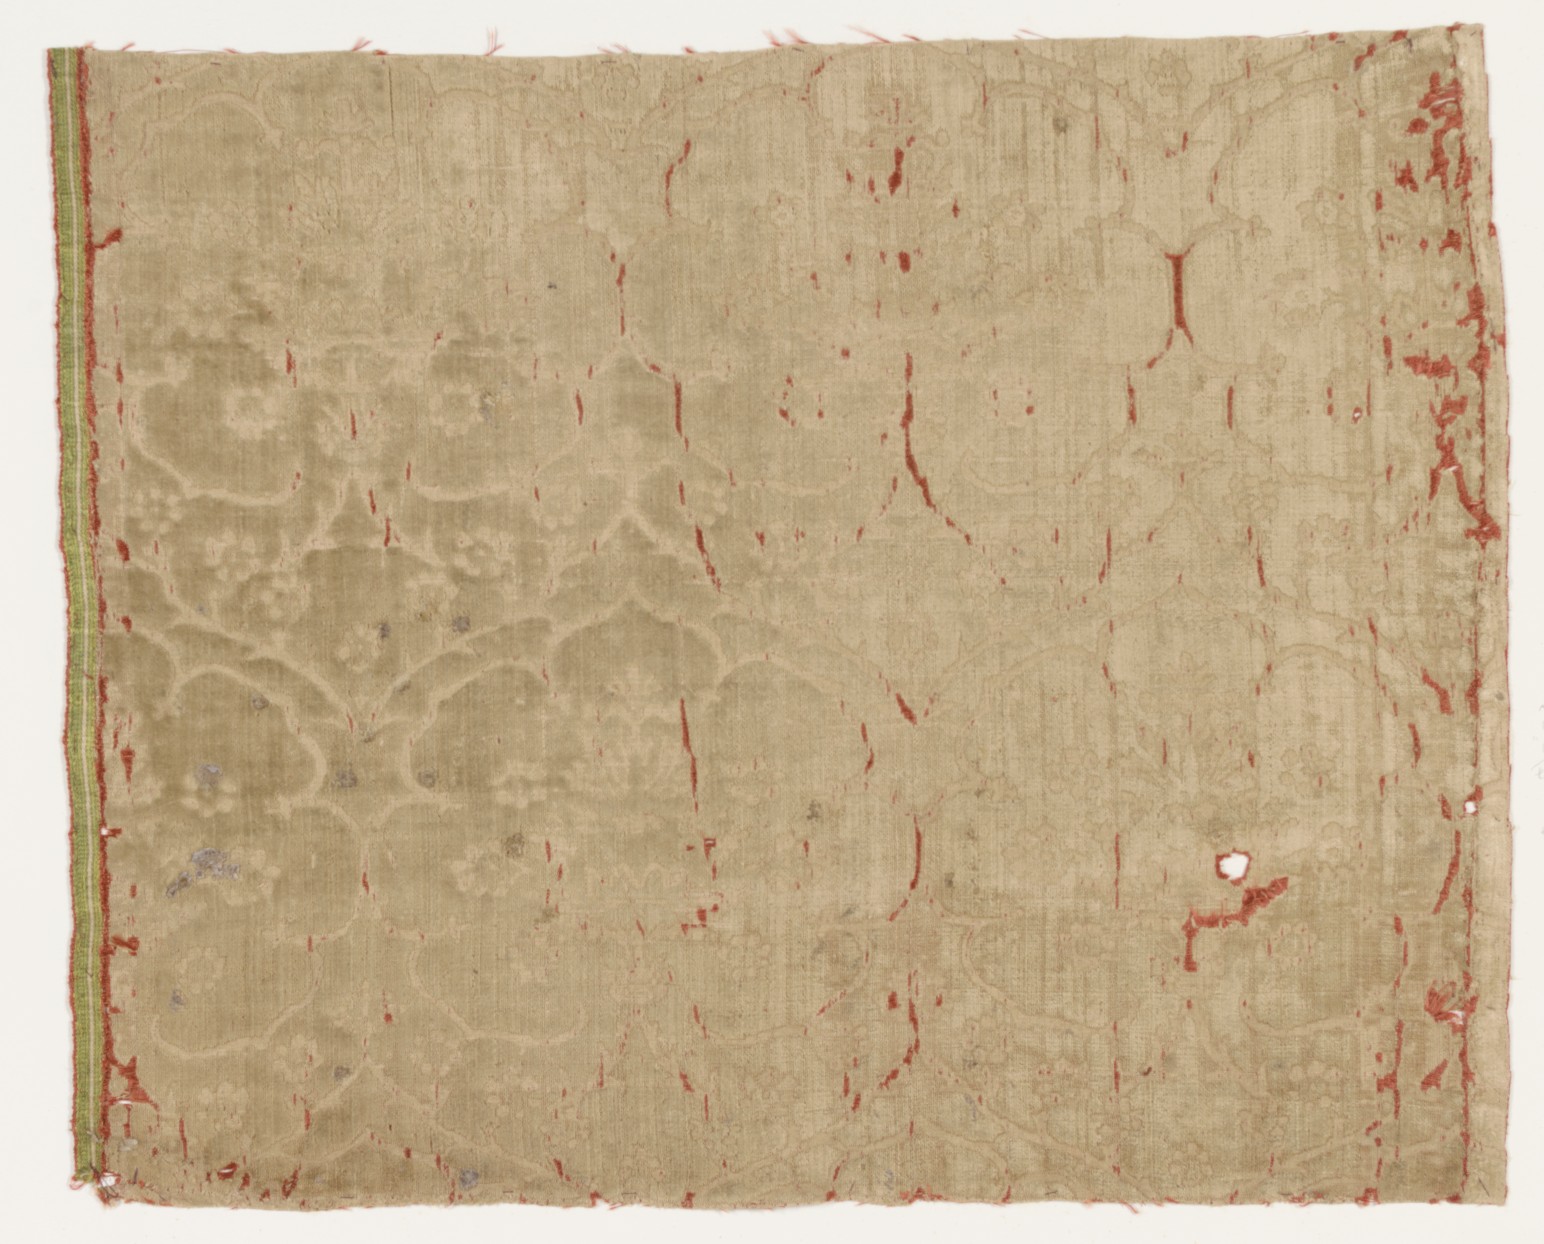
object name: fragment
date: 1501-1533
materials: silk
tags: flowers